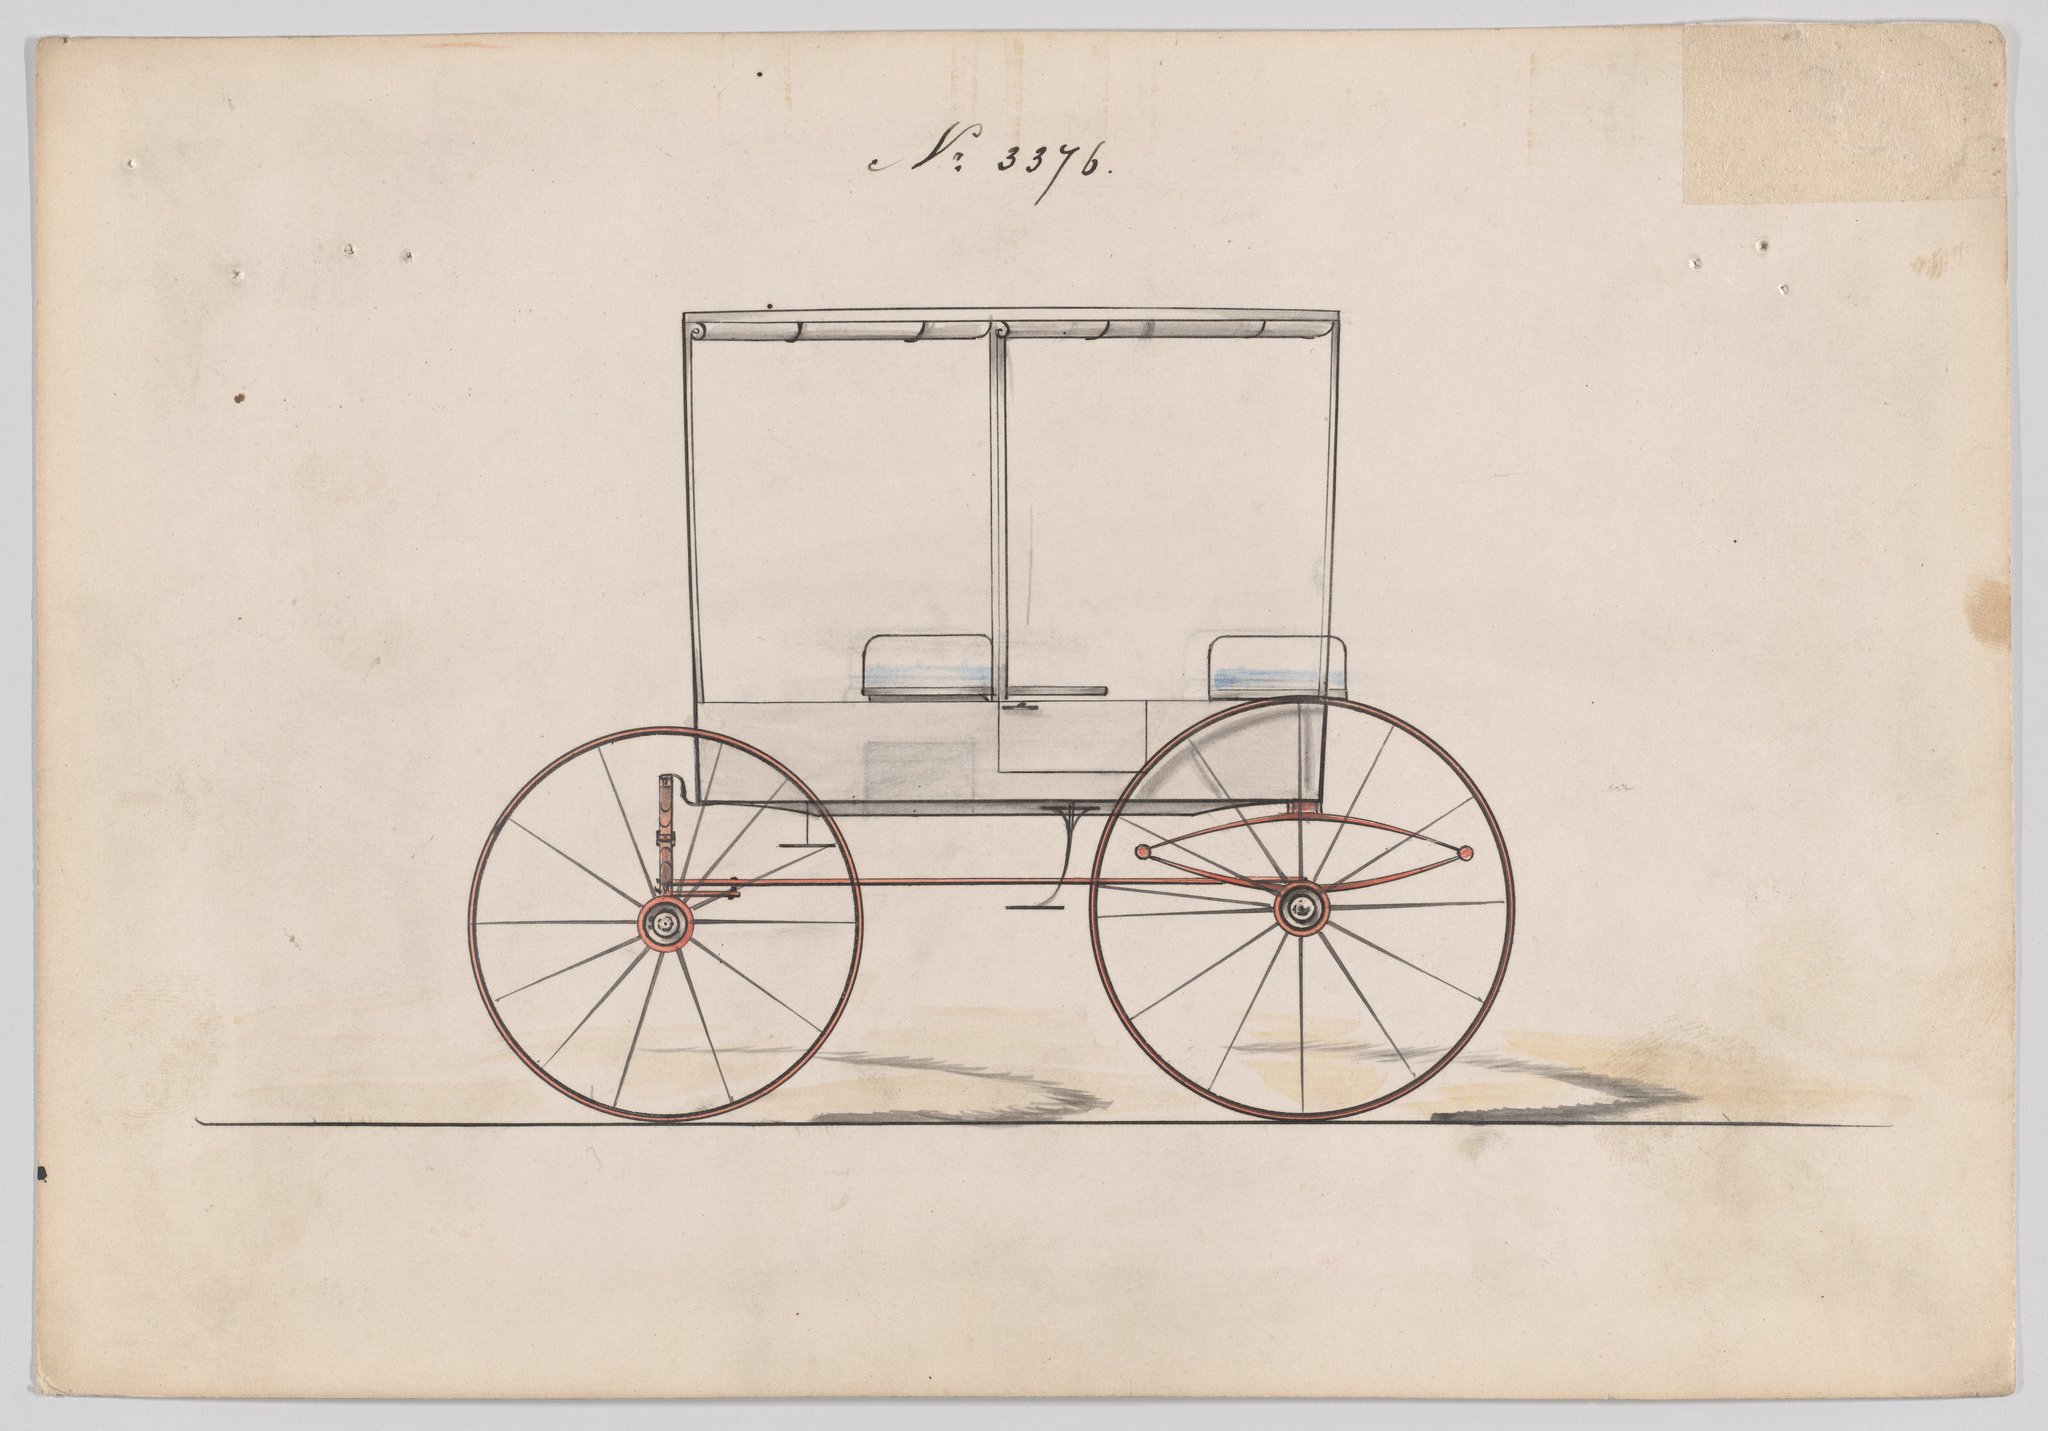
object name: drawing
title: Design for 6 seat Rockaway, no. 3376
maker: brewster & co.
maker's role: manufacturer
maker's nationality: american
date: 1877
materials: gouache, ink, watercolor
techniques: pen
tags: carriages